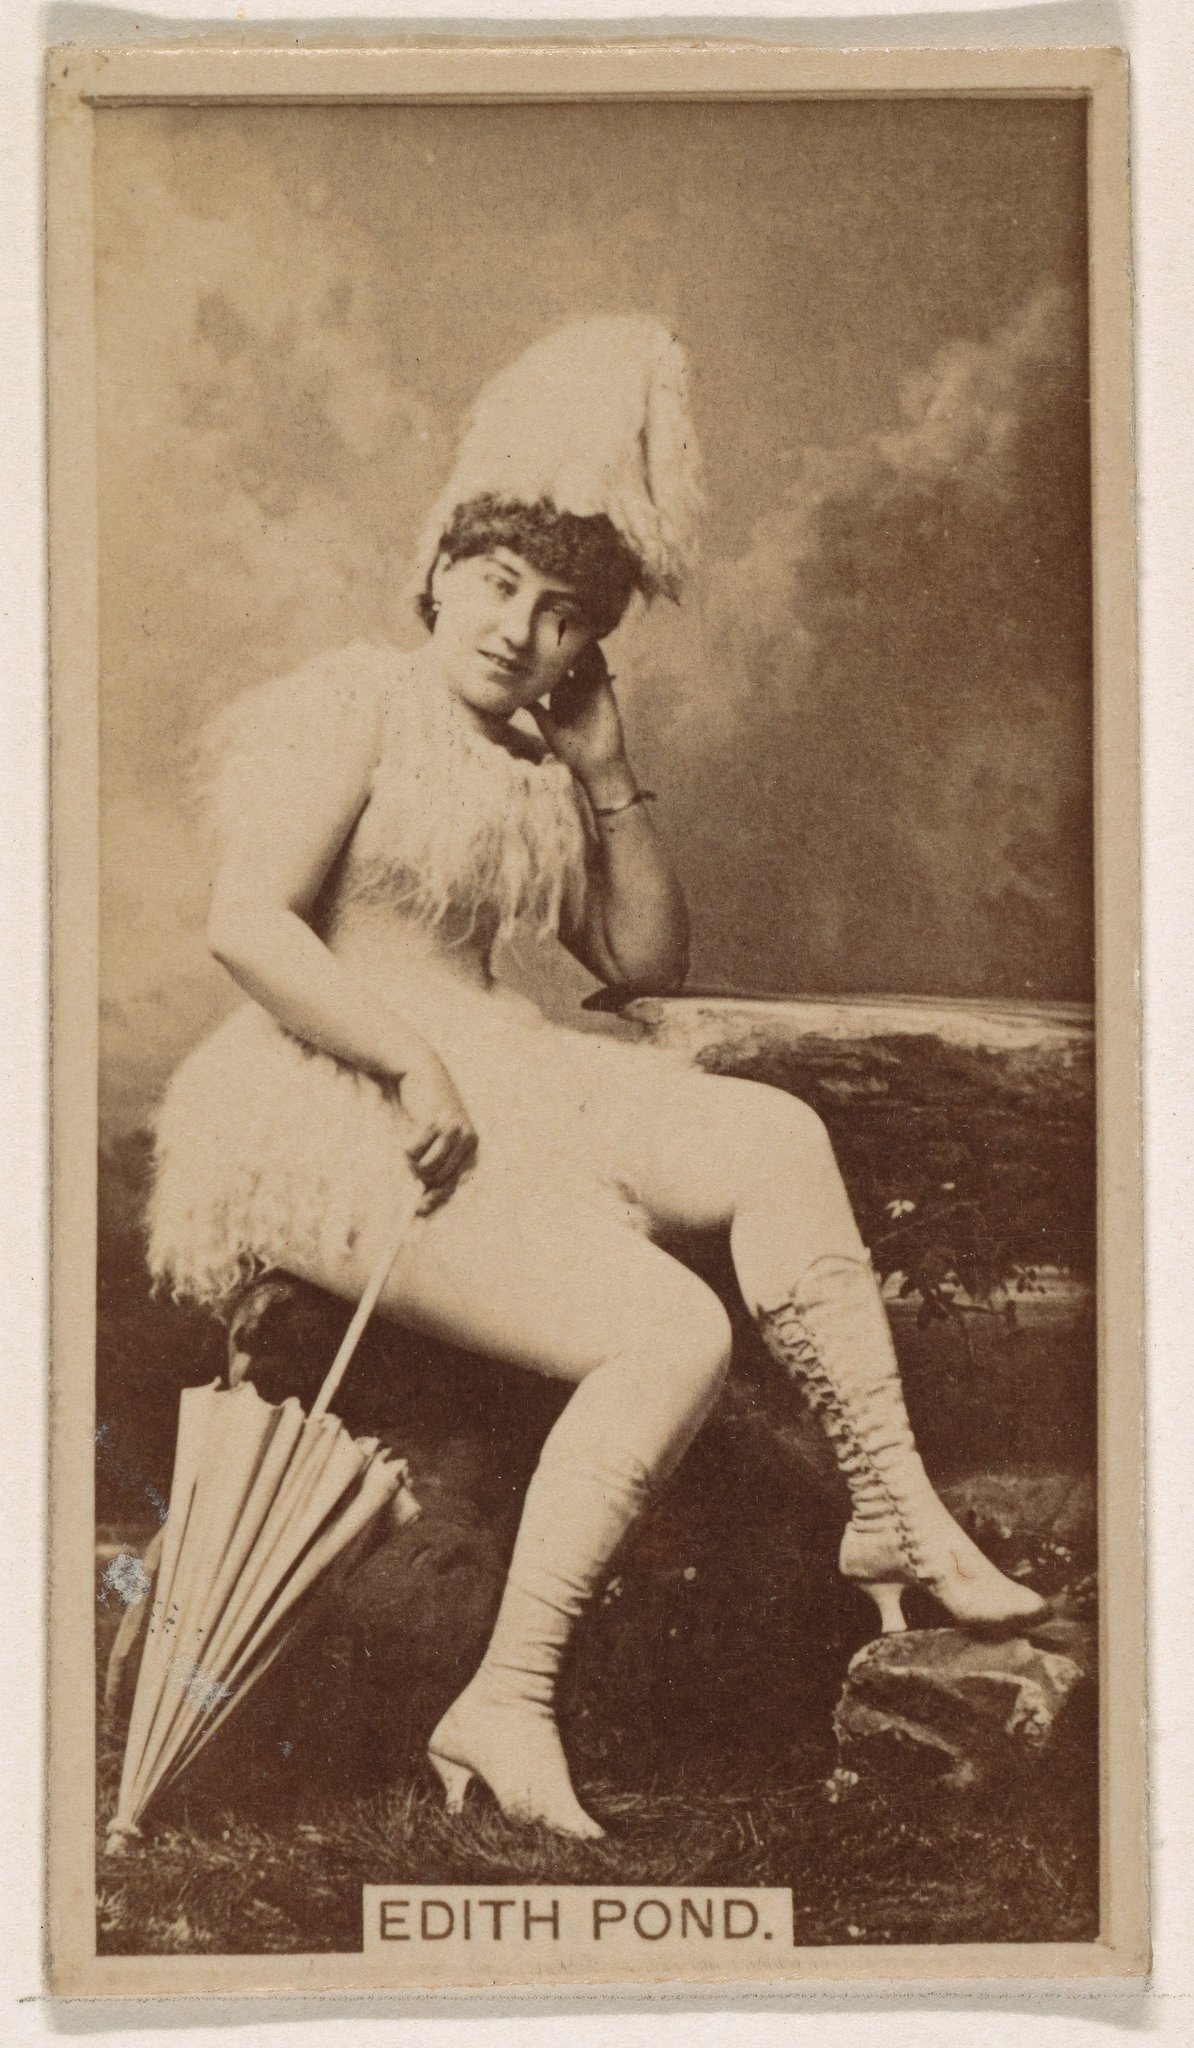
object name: photograph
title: Edith Pond, from the Actresses series (N245) issued by Kinney Brothers to promote Sweet Caporal Cigarettes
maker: kinney brothers tobacco company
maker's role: publisher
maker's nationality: american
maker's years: 1869-2011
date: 1890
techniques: albumen silver print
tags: portraits,women,actresses